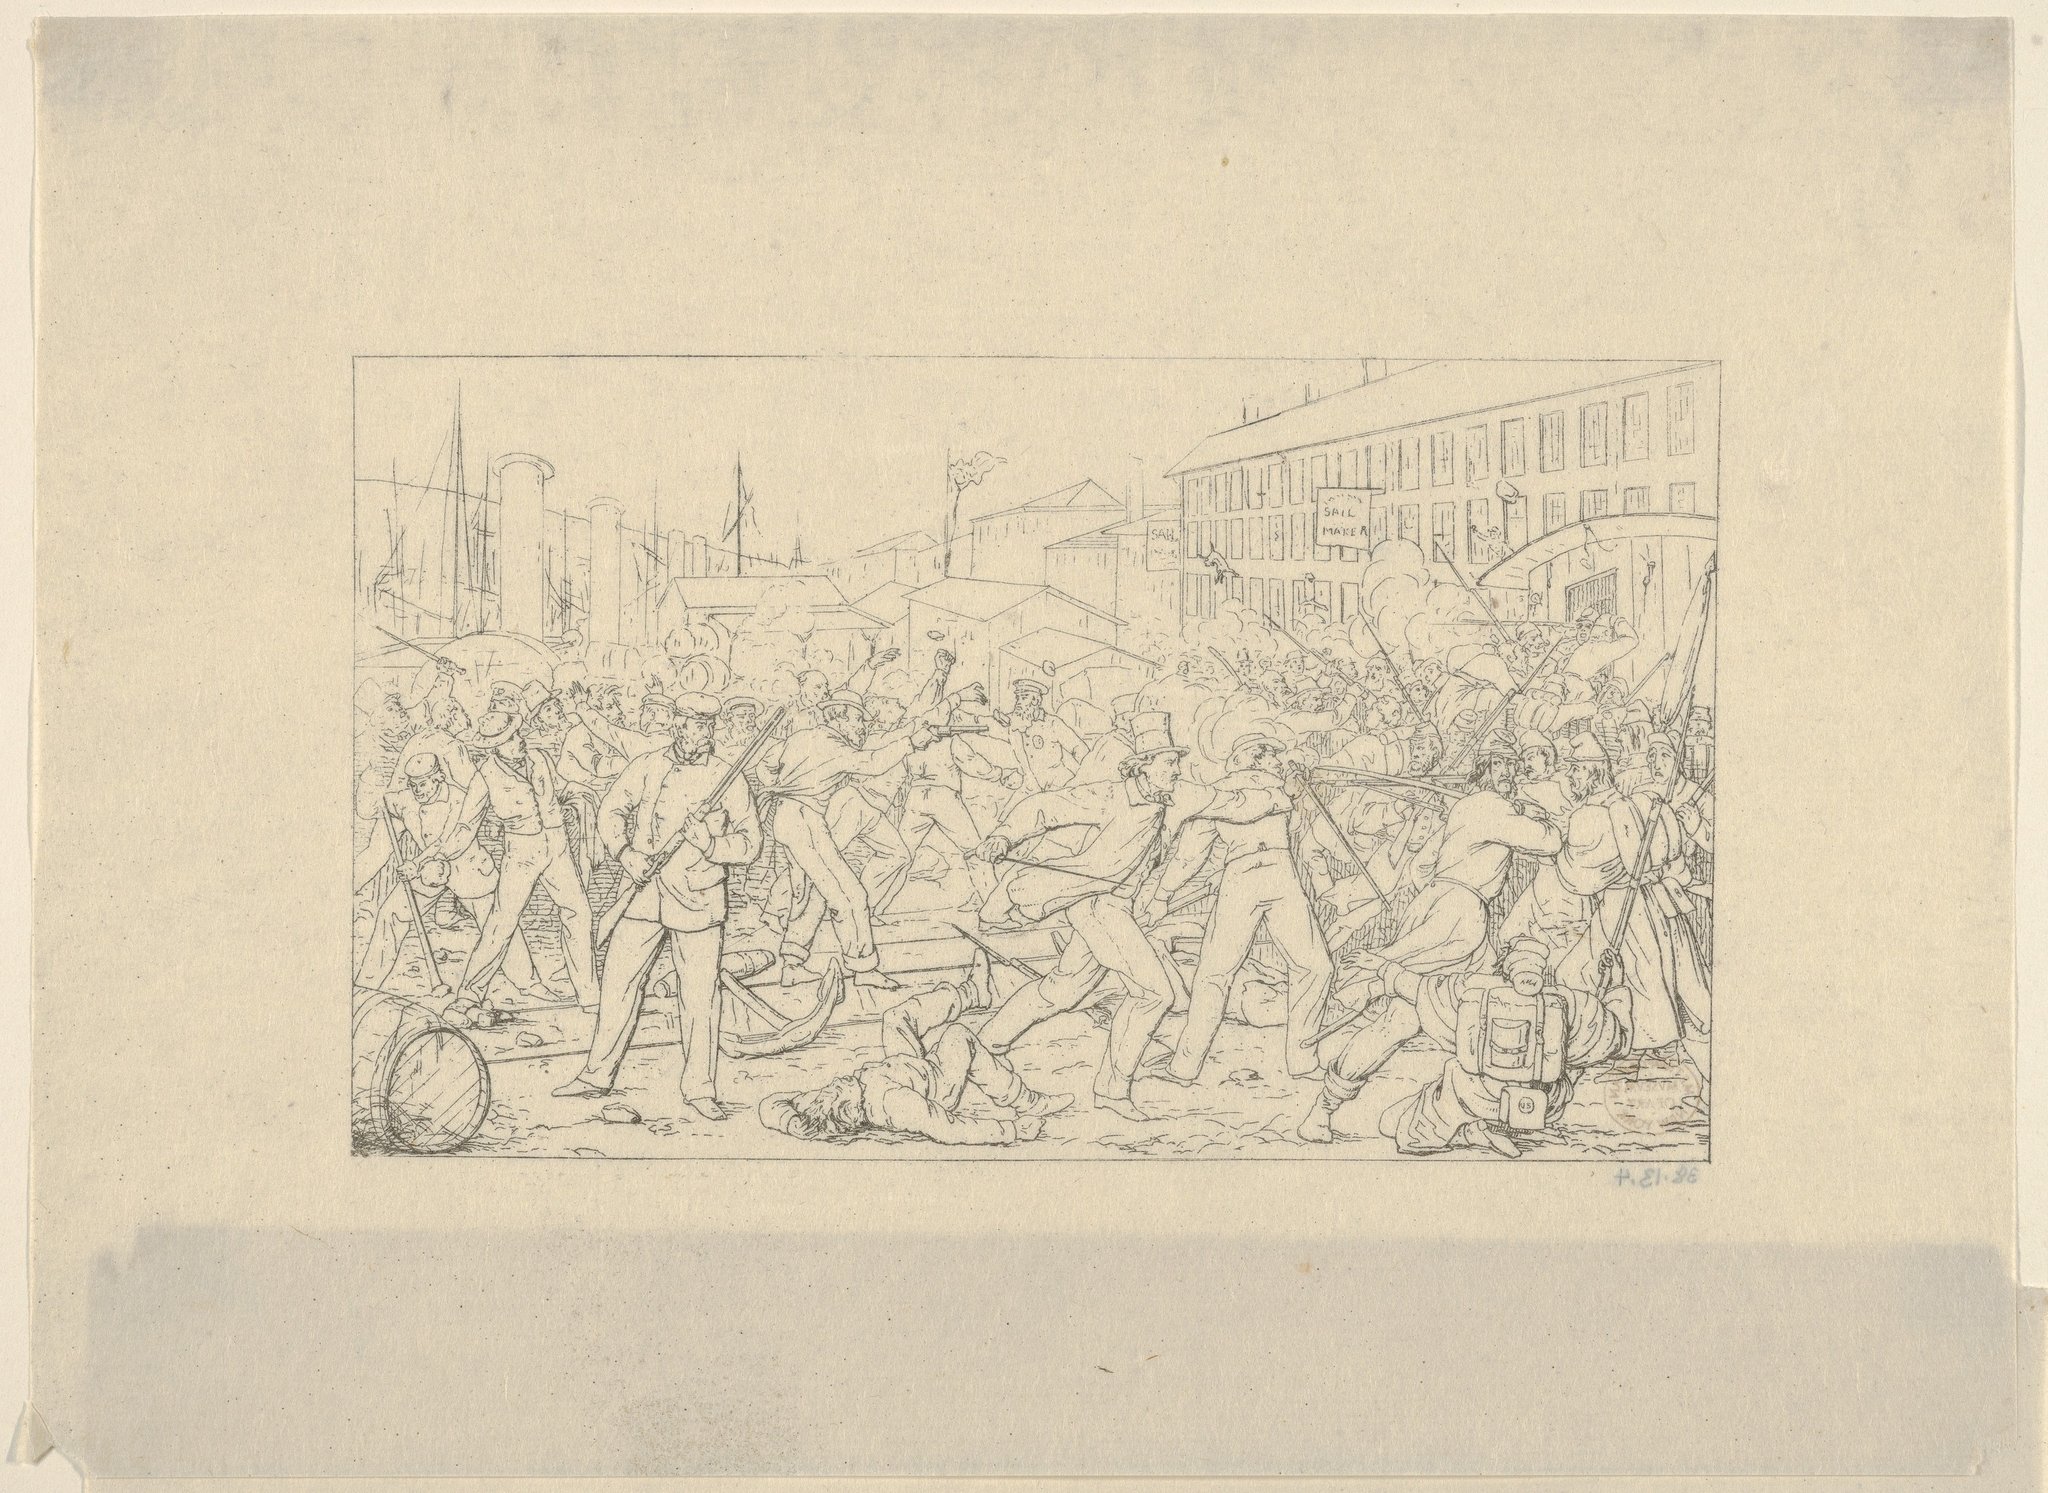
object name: print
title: Battle in Baltimore, April 19, 1861 (from Confederate War Etchings)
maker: adalbert john volck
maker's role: artist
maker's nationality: american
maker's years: 1828-1912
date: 1861-1863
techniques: etching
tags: battles,soldiers,american civil war